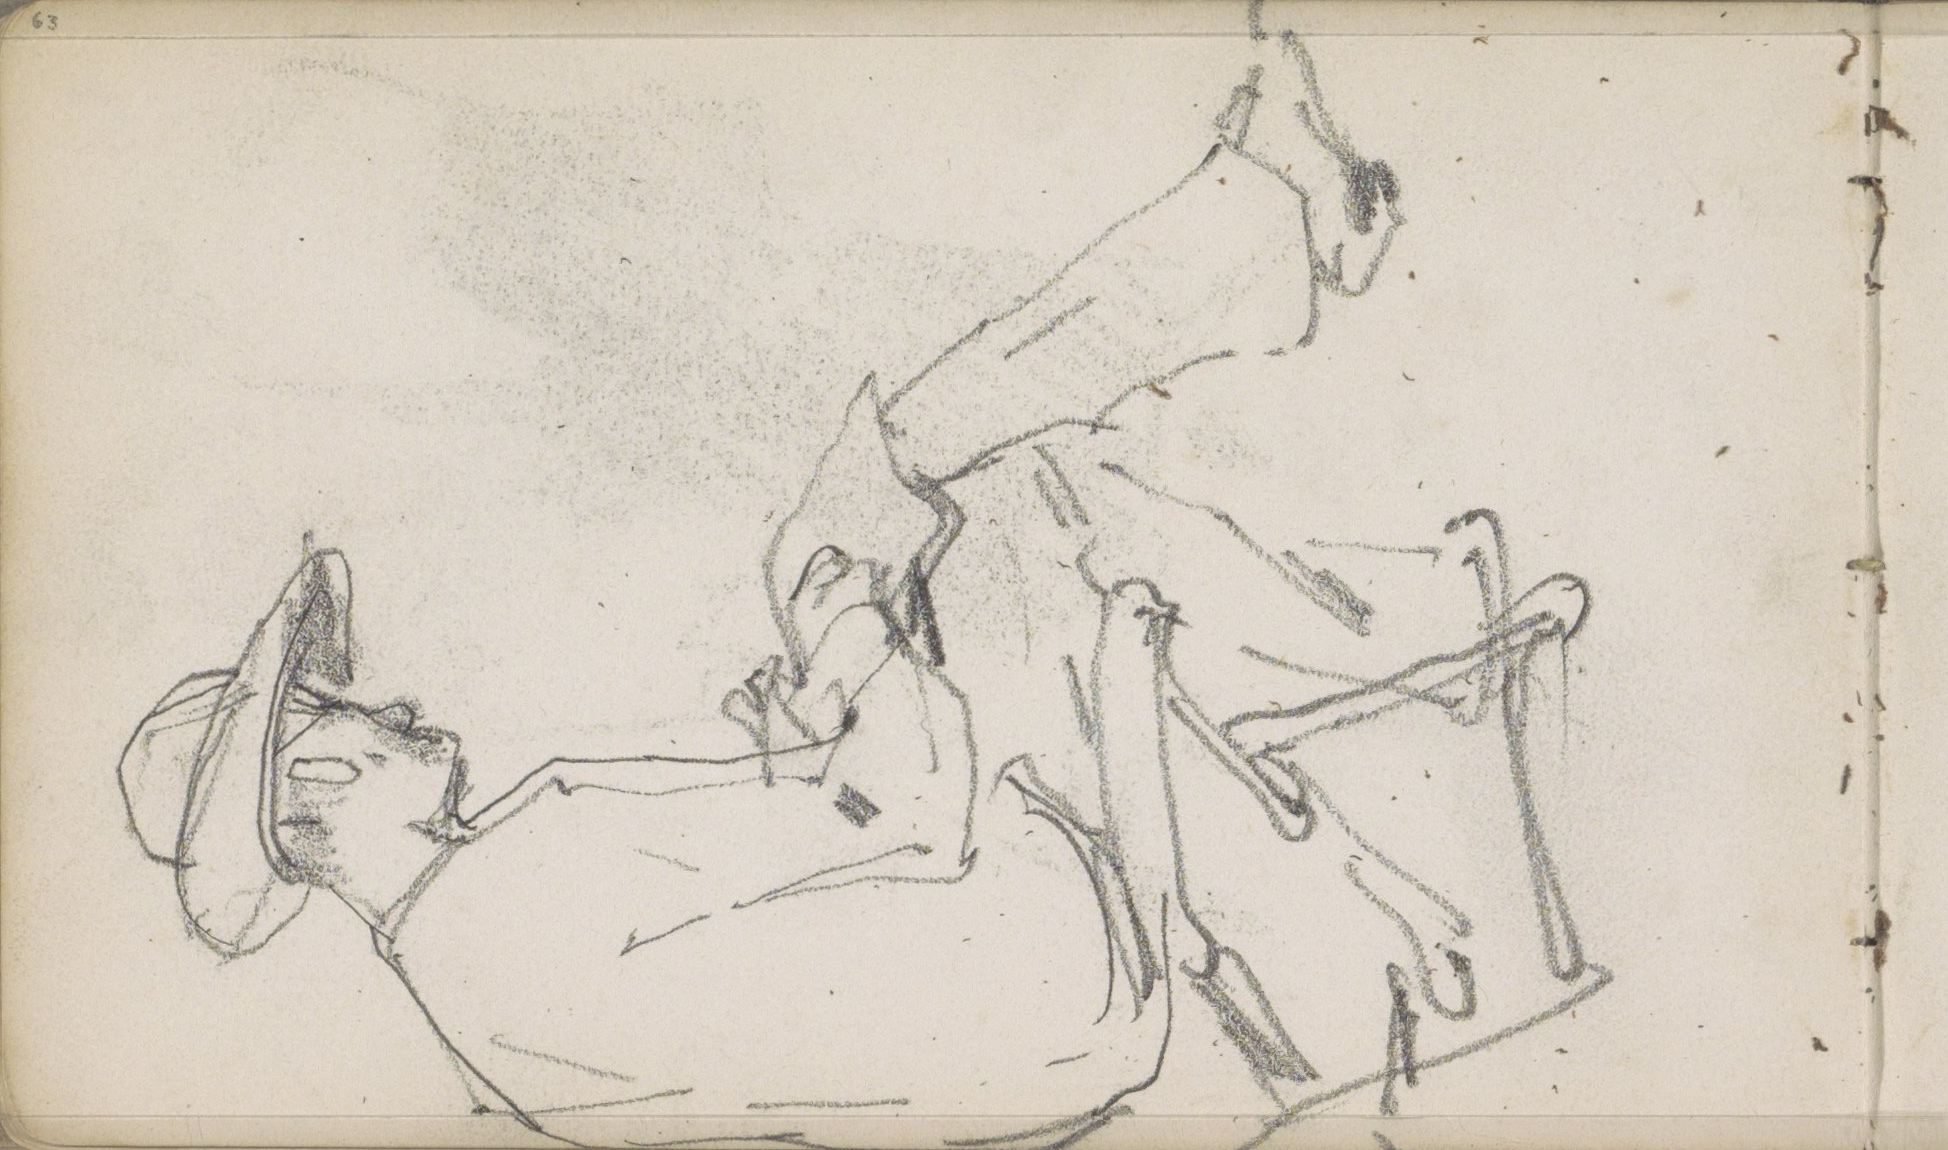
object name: sketchbook leaf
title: Zittende man met hoed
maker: george hendrik breitner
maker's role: draughtsman, painter, print maker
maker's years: 1857-1923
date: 1881-1883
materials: paper, pencil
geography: north brabant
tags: sitting on an elevation (+ sideview, profile), adult man, chair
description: Voor hem een blad papier of boek. Mogelijk schrijft of tekent hij. Pagina 63 uit een schetsboek met 42 bladen.